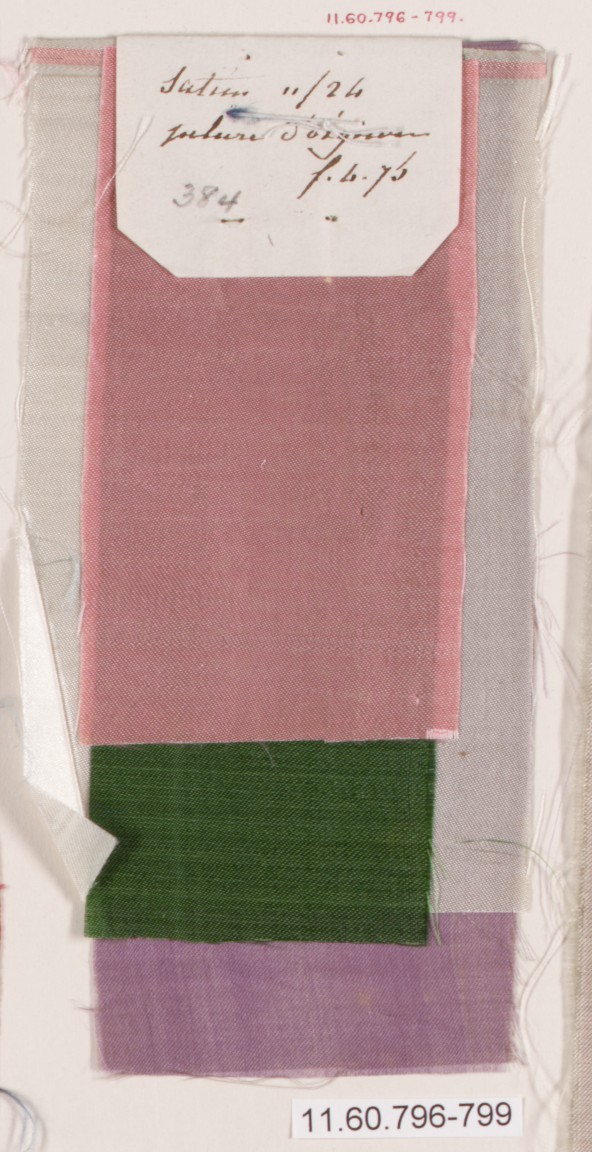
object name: sample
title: Samples (4)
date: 1801-1833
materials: silk